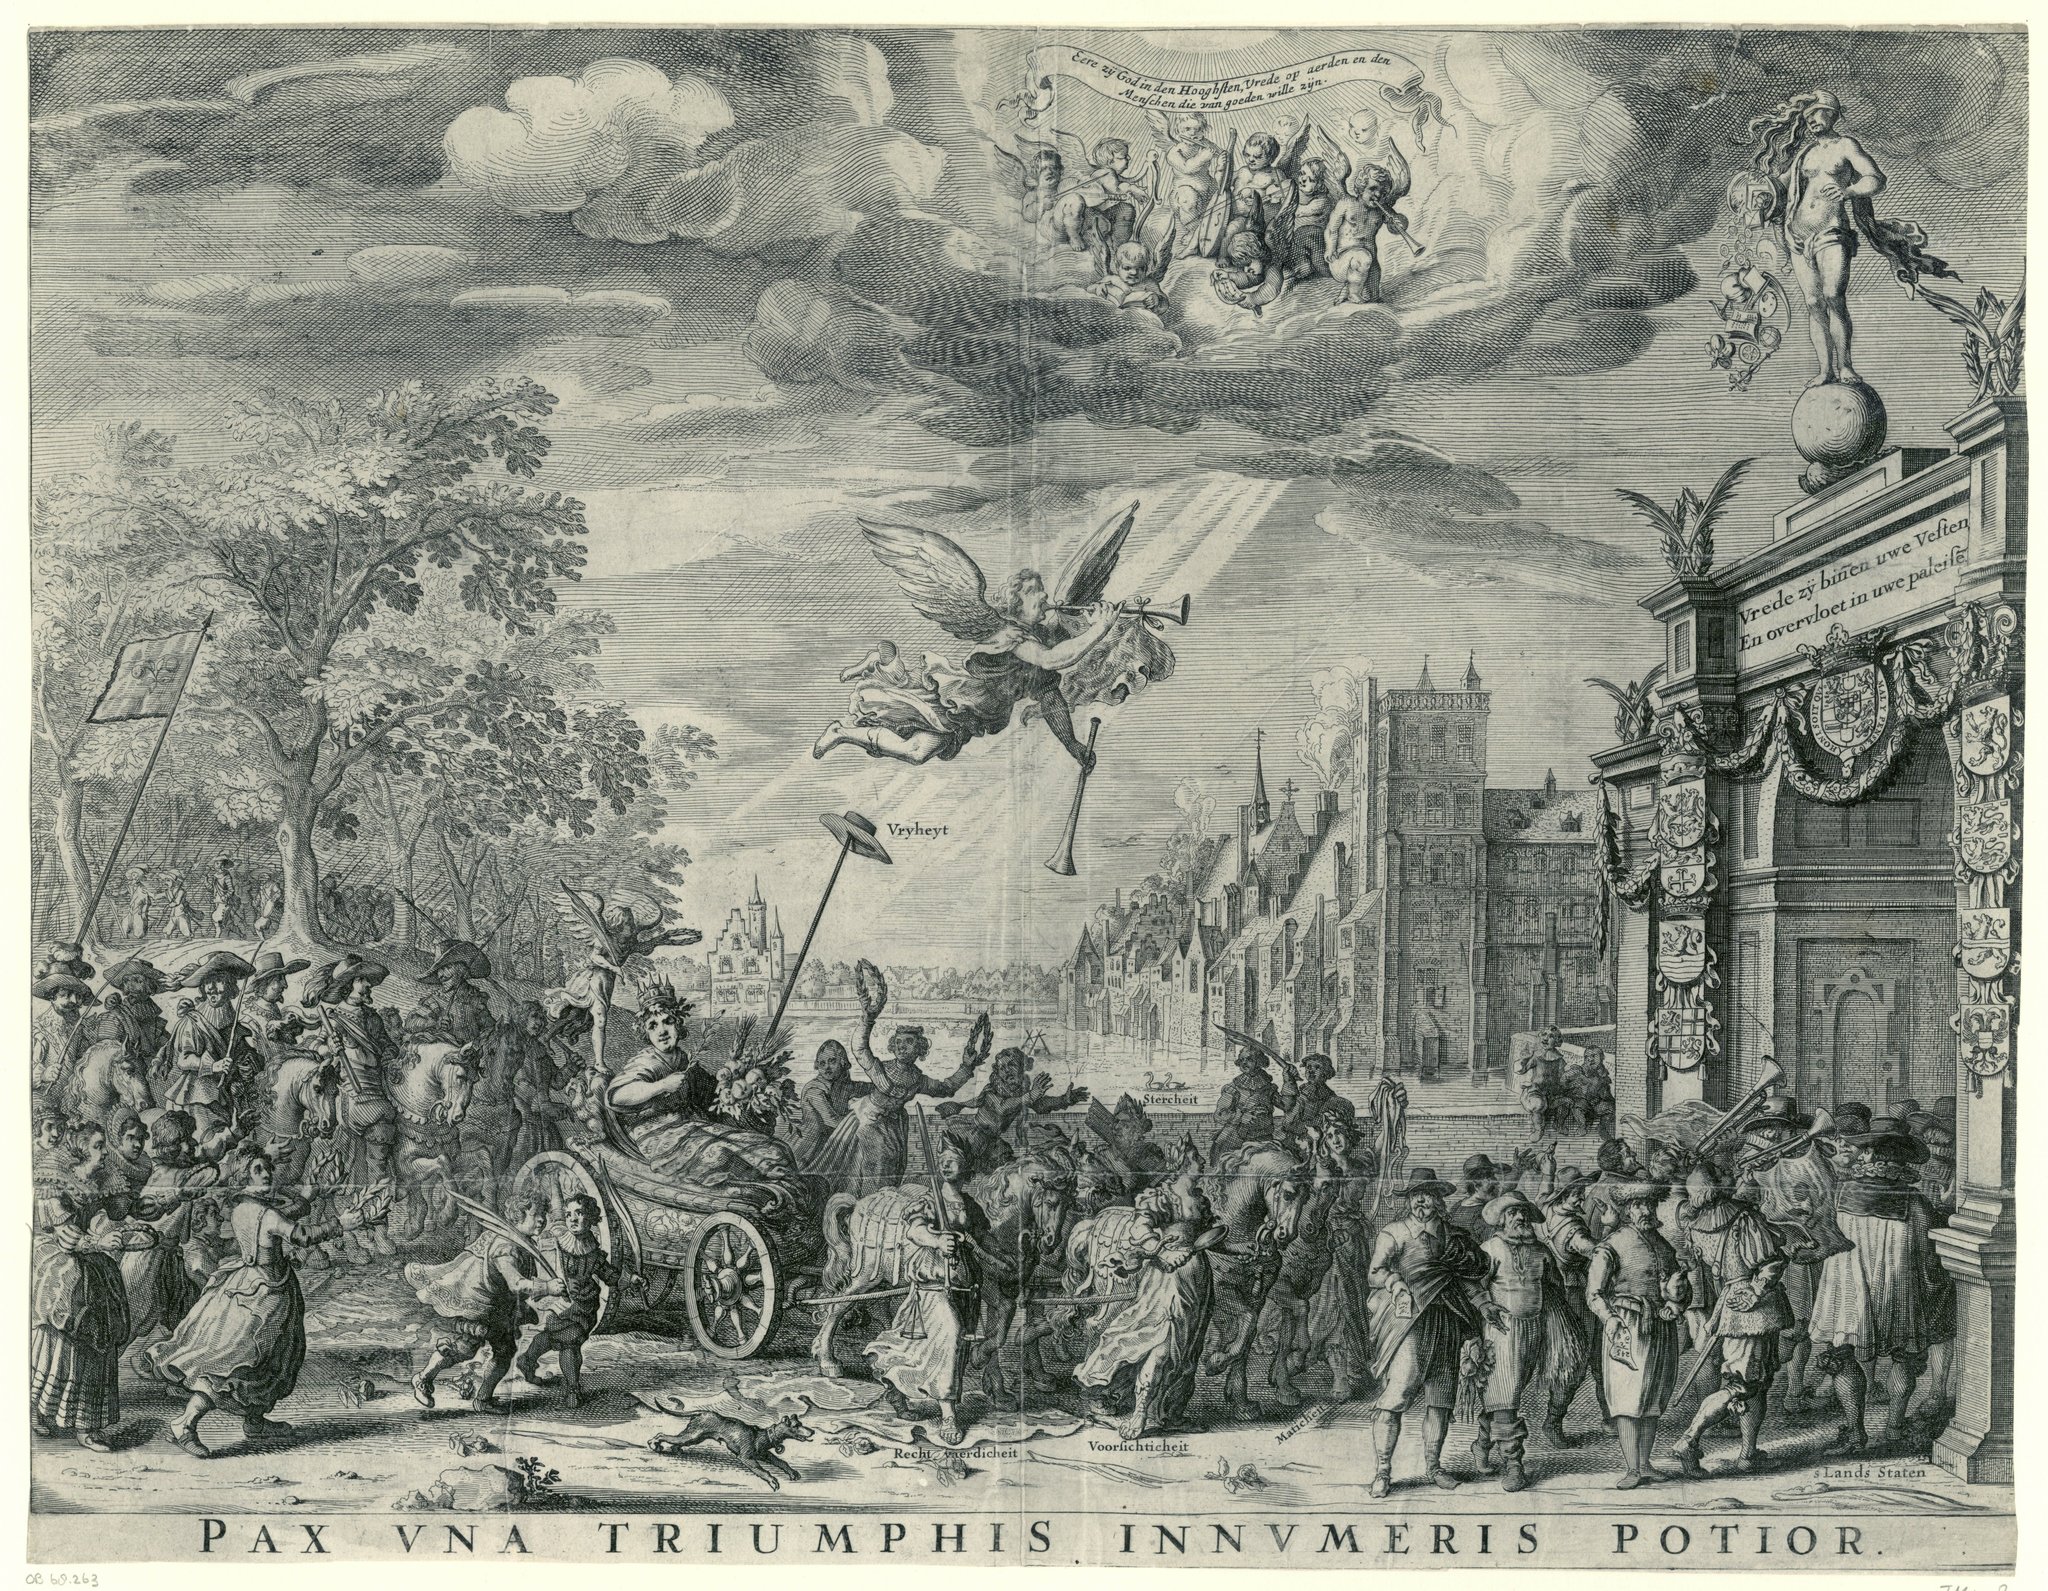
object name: propagandaprent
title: Allegorie op de Vrede van Munster, 1648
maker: salomon savery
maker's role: print maker, publisher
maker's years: 1594-1683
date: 1648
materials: paper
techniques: engraving, etching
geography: amsterdam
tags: symbols, allegories of peace, 'pax'; 'pace' (ripa), peace and prosperity, 'pax et abundantia', fame; 'fama', 'fama buona', 'fama chiara' (ripa), coat of arms (as symbol of the state, etc.) (+ province; provincial), armorial bearing, heraldry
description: Allegorie op de Vrede van Munster. Triomfoptocht van de triomfwagen van de Vrede die langs de Vijverberg door een ereboog Den Haag ingeleid wordt. Op de triomfpoort het wapen van Frederik Hendrik en acht provinciewapens, bovenop de poort Fortuna die rijkdommen schenkt. In de lucht de Faam en daarboven een engelenkoor. De oorspronkelijk plaat bevatte een voorstelling ter ere van Frederik Hendrik na de inname van Den Bosch in 1629. In deze prent neemt Vrede de plaats van Frederik Hendrik in. Bij deze prent hoort een vers in drie kolommen van Reyer Anslo met de titel 'Nederlandts vredevreught'.